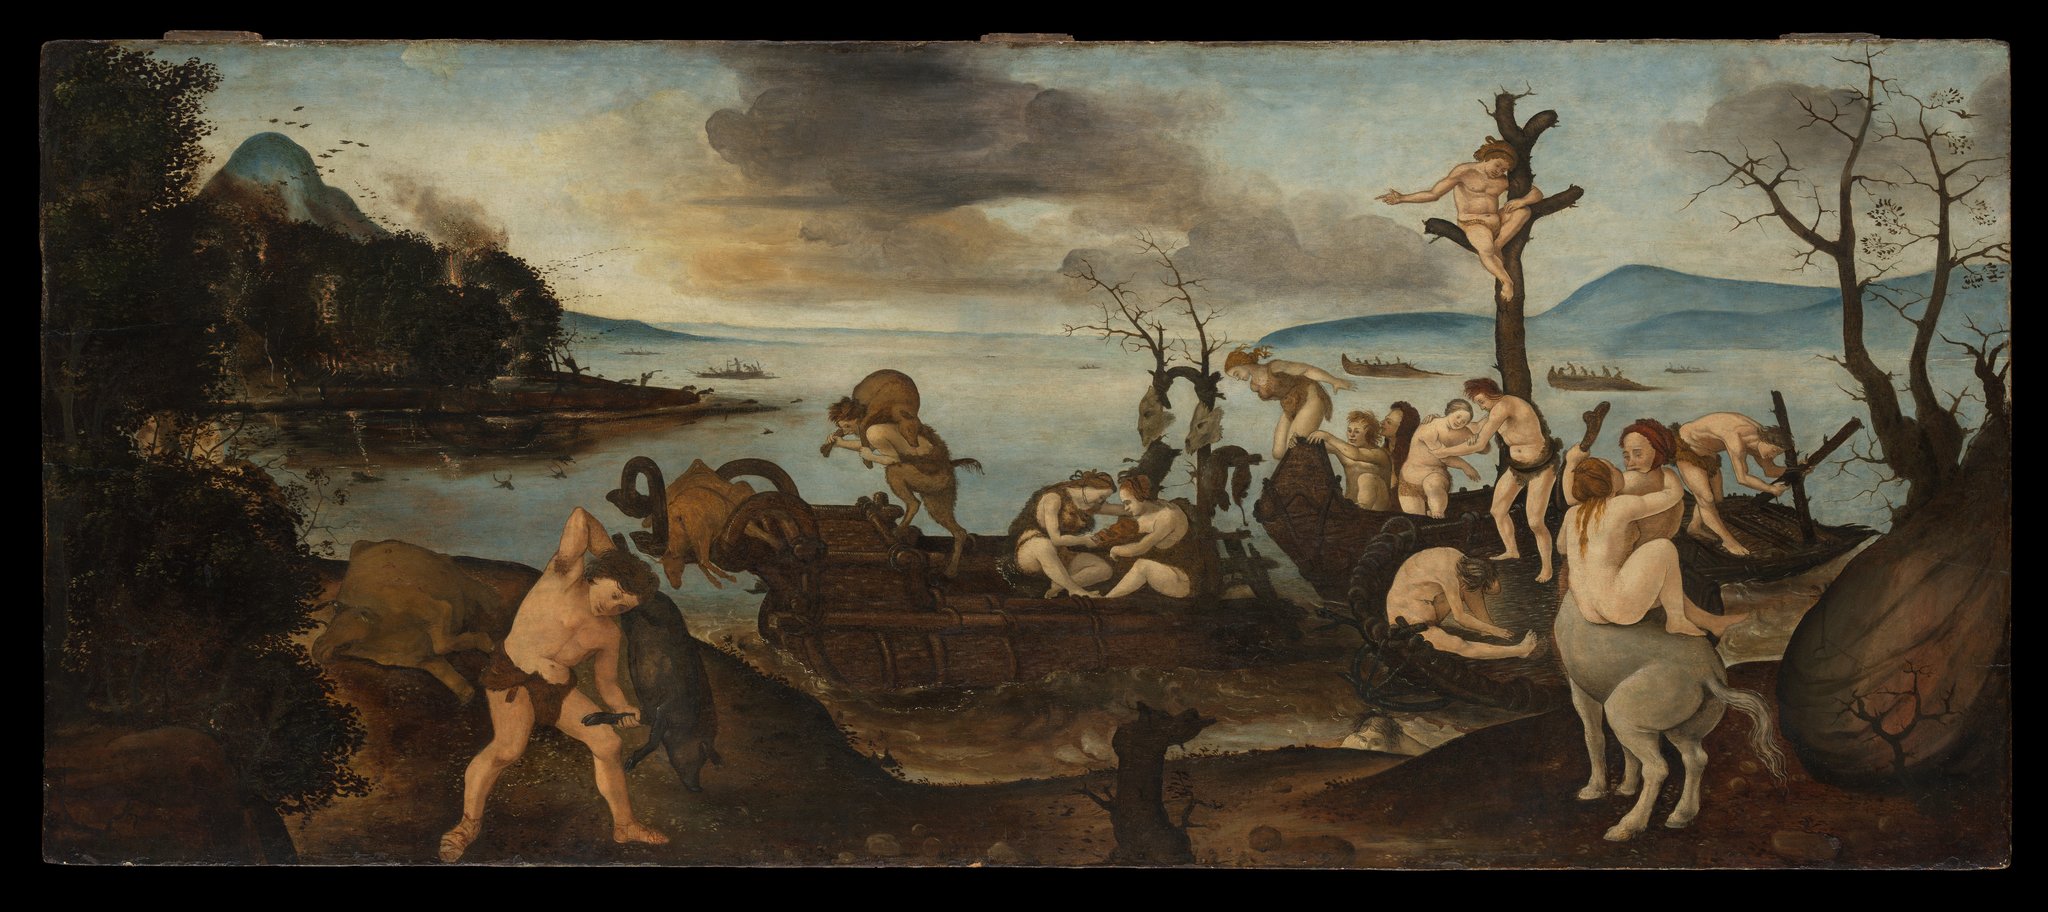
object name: painting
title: The Return from the Hunt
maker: piero di cosimo (piero di lorenzo di piero d'antonio)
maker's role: artist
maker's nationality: italian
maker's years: 1462-1522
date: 1494-1500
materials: oil, paint, wood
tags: men,women,female nudes,centaurs,satyrs,pigs,boats